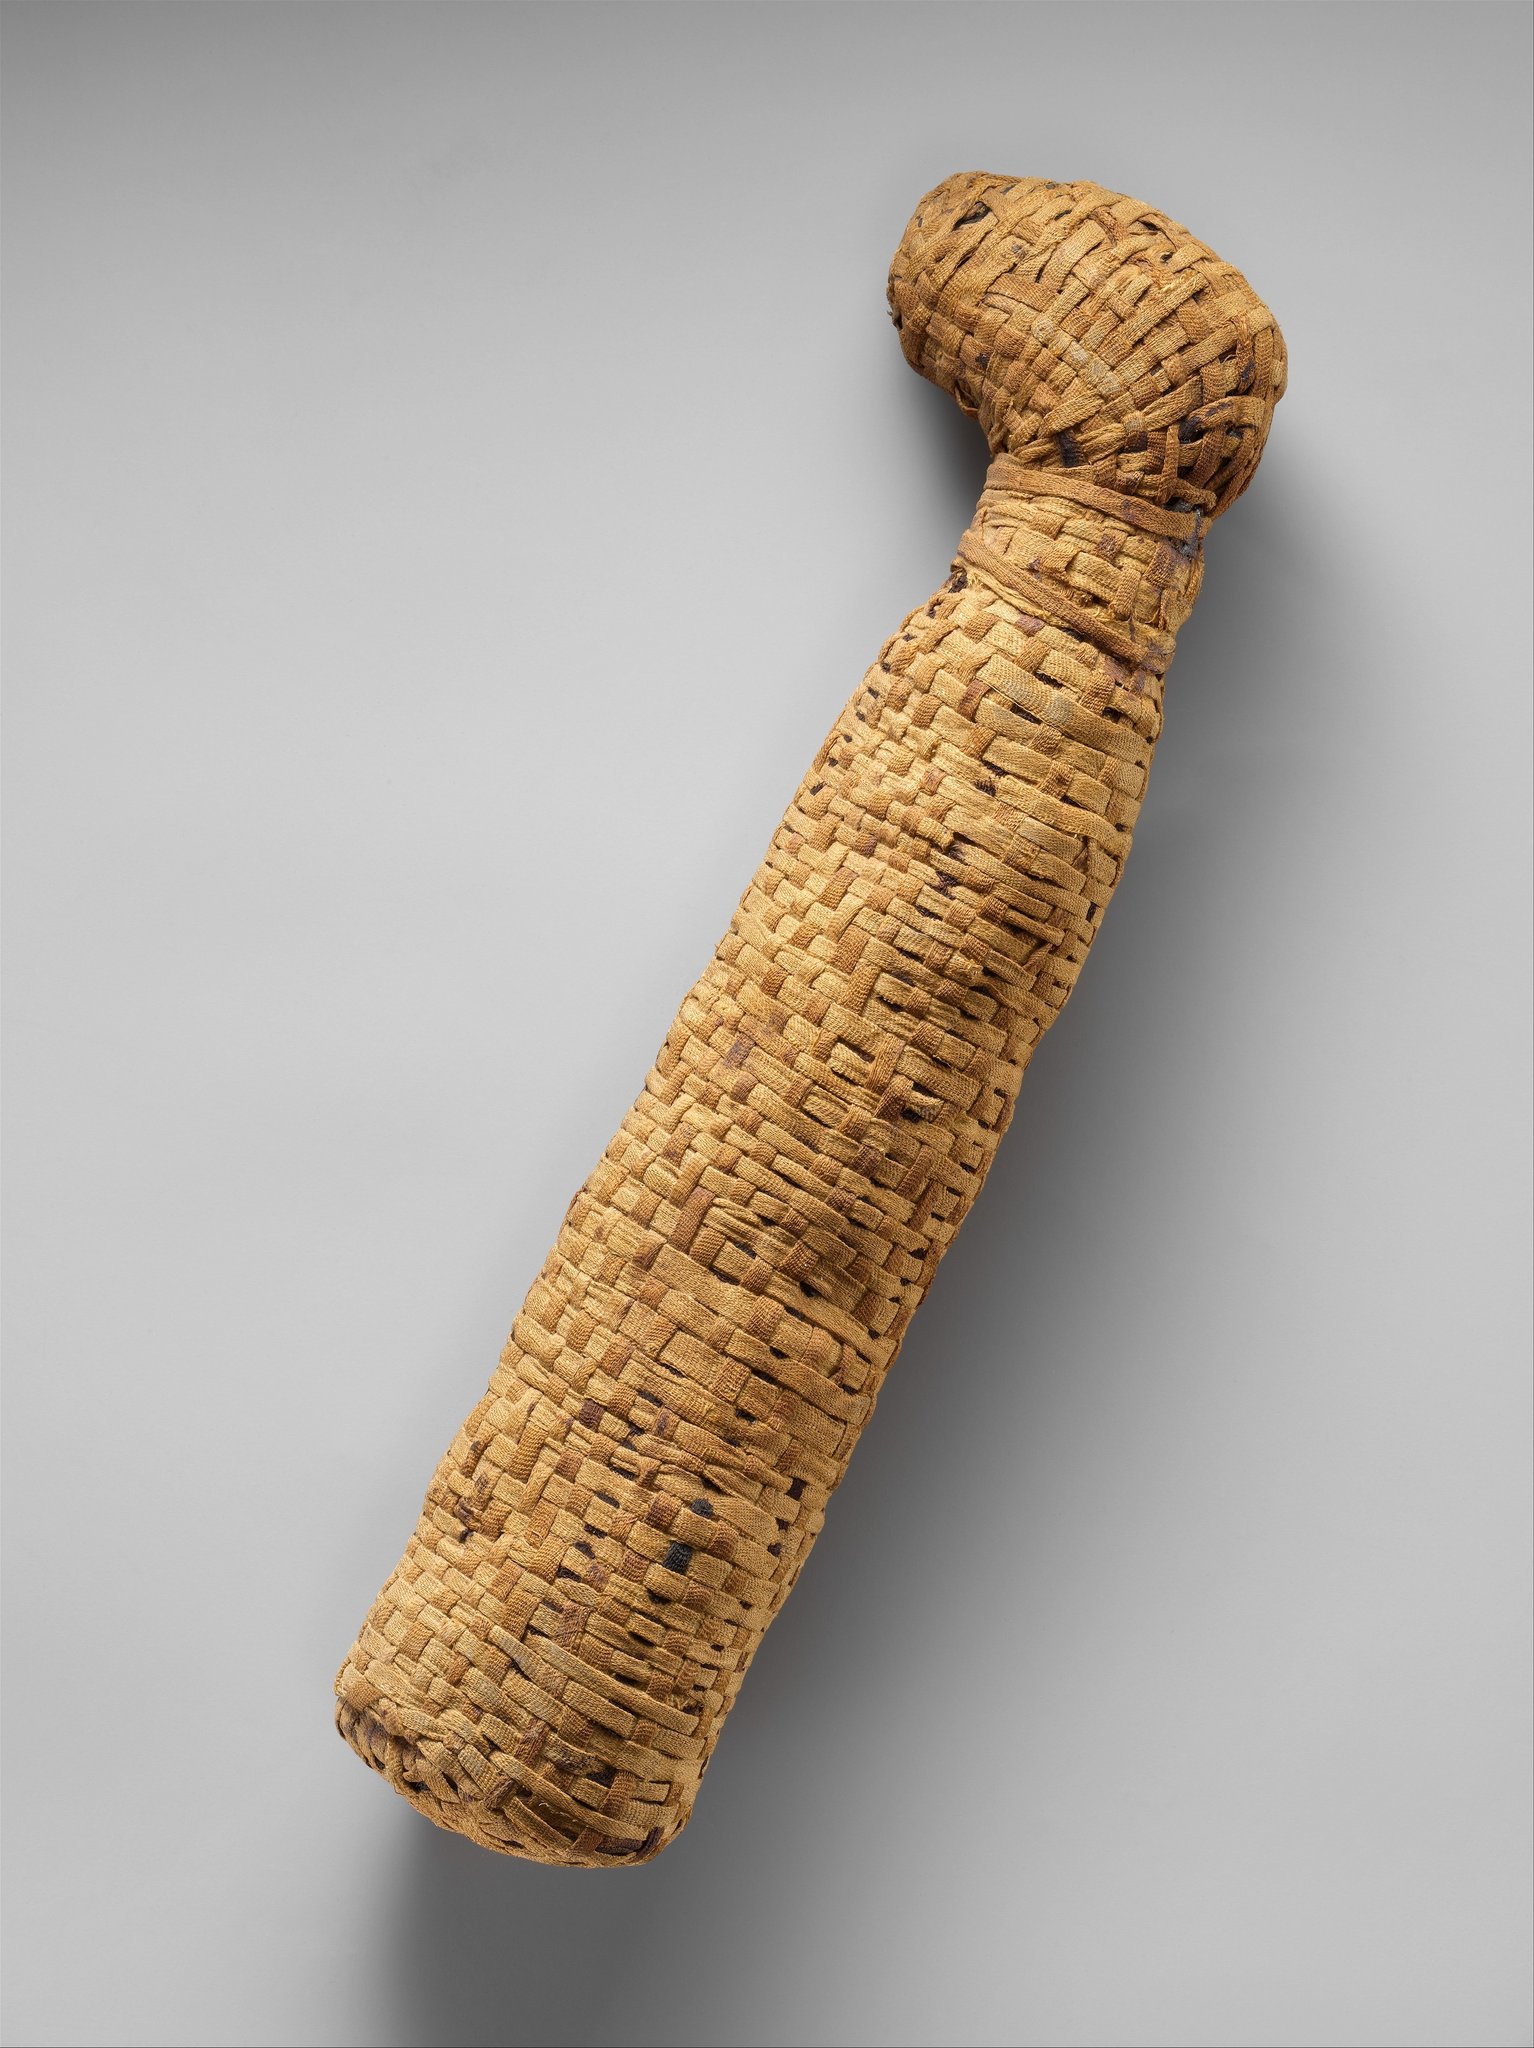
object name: mummy, cat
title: Sacred animal mummy of a cat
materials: linen, paint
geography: egypt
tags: cats,mummies